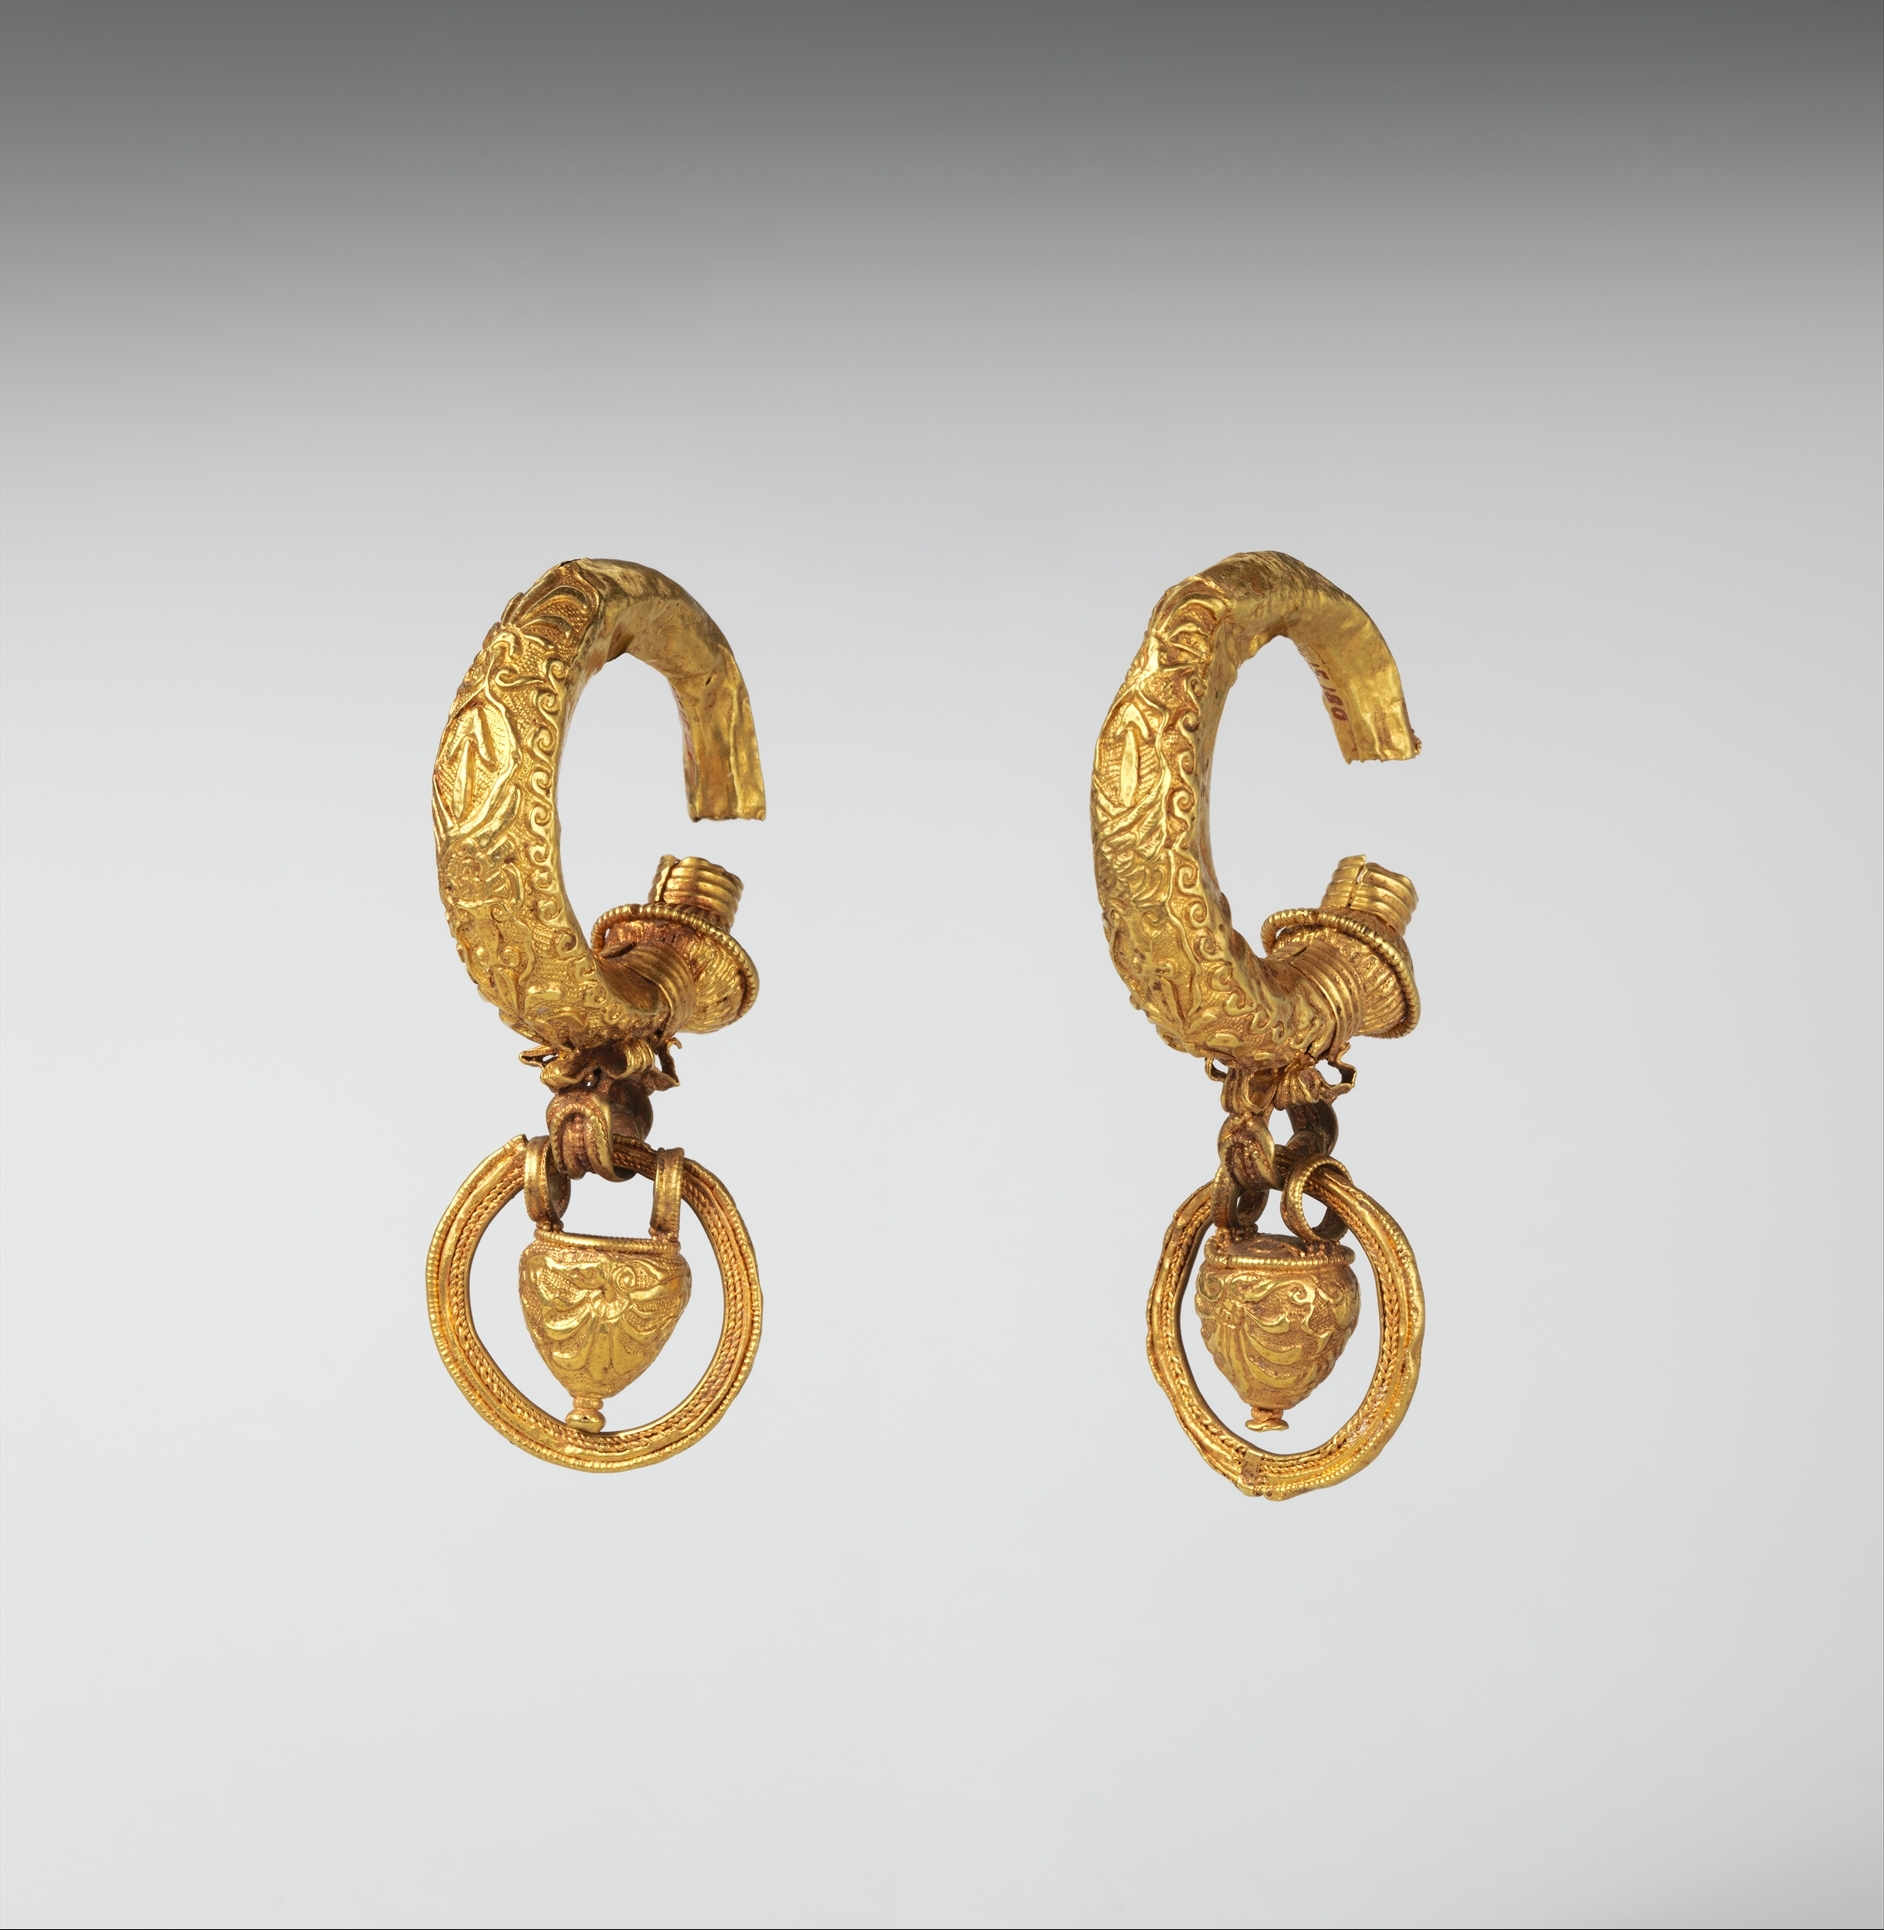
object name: earring, trumpet shaped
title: Gold earrings with pendant vase and ring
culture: etruscan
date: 400-201 BCE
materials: gold